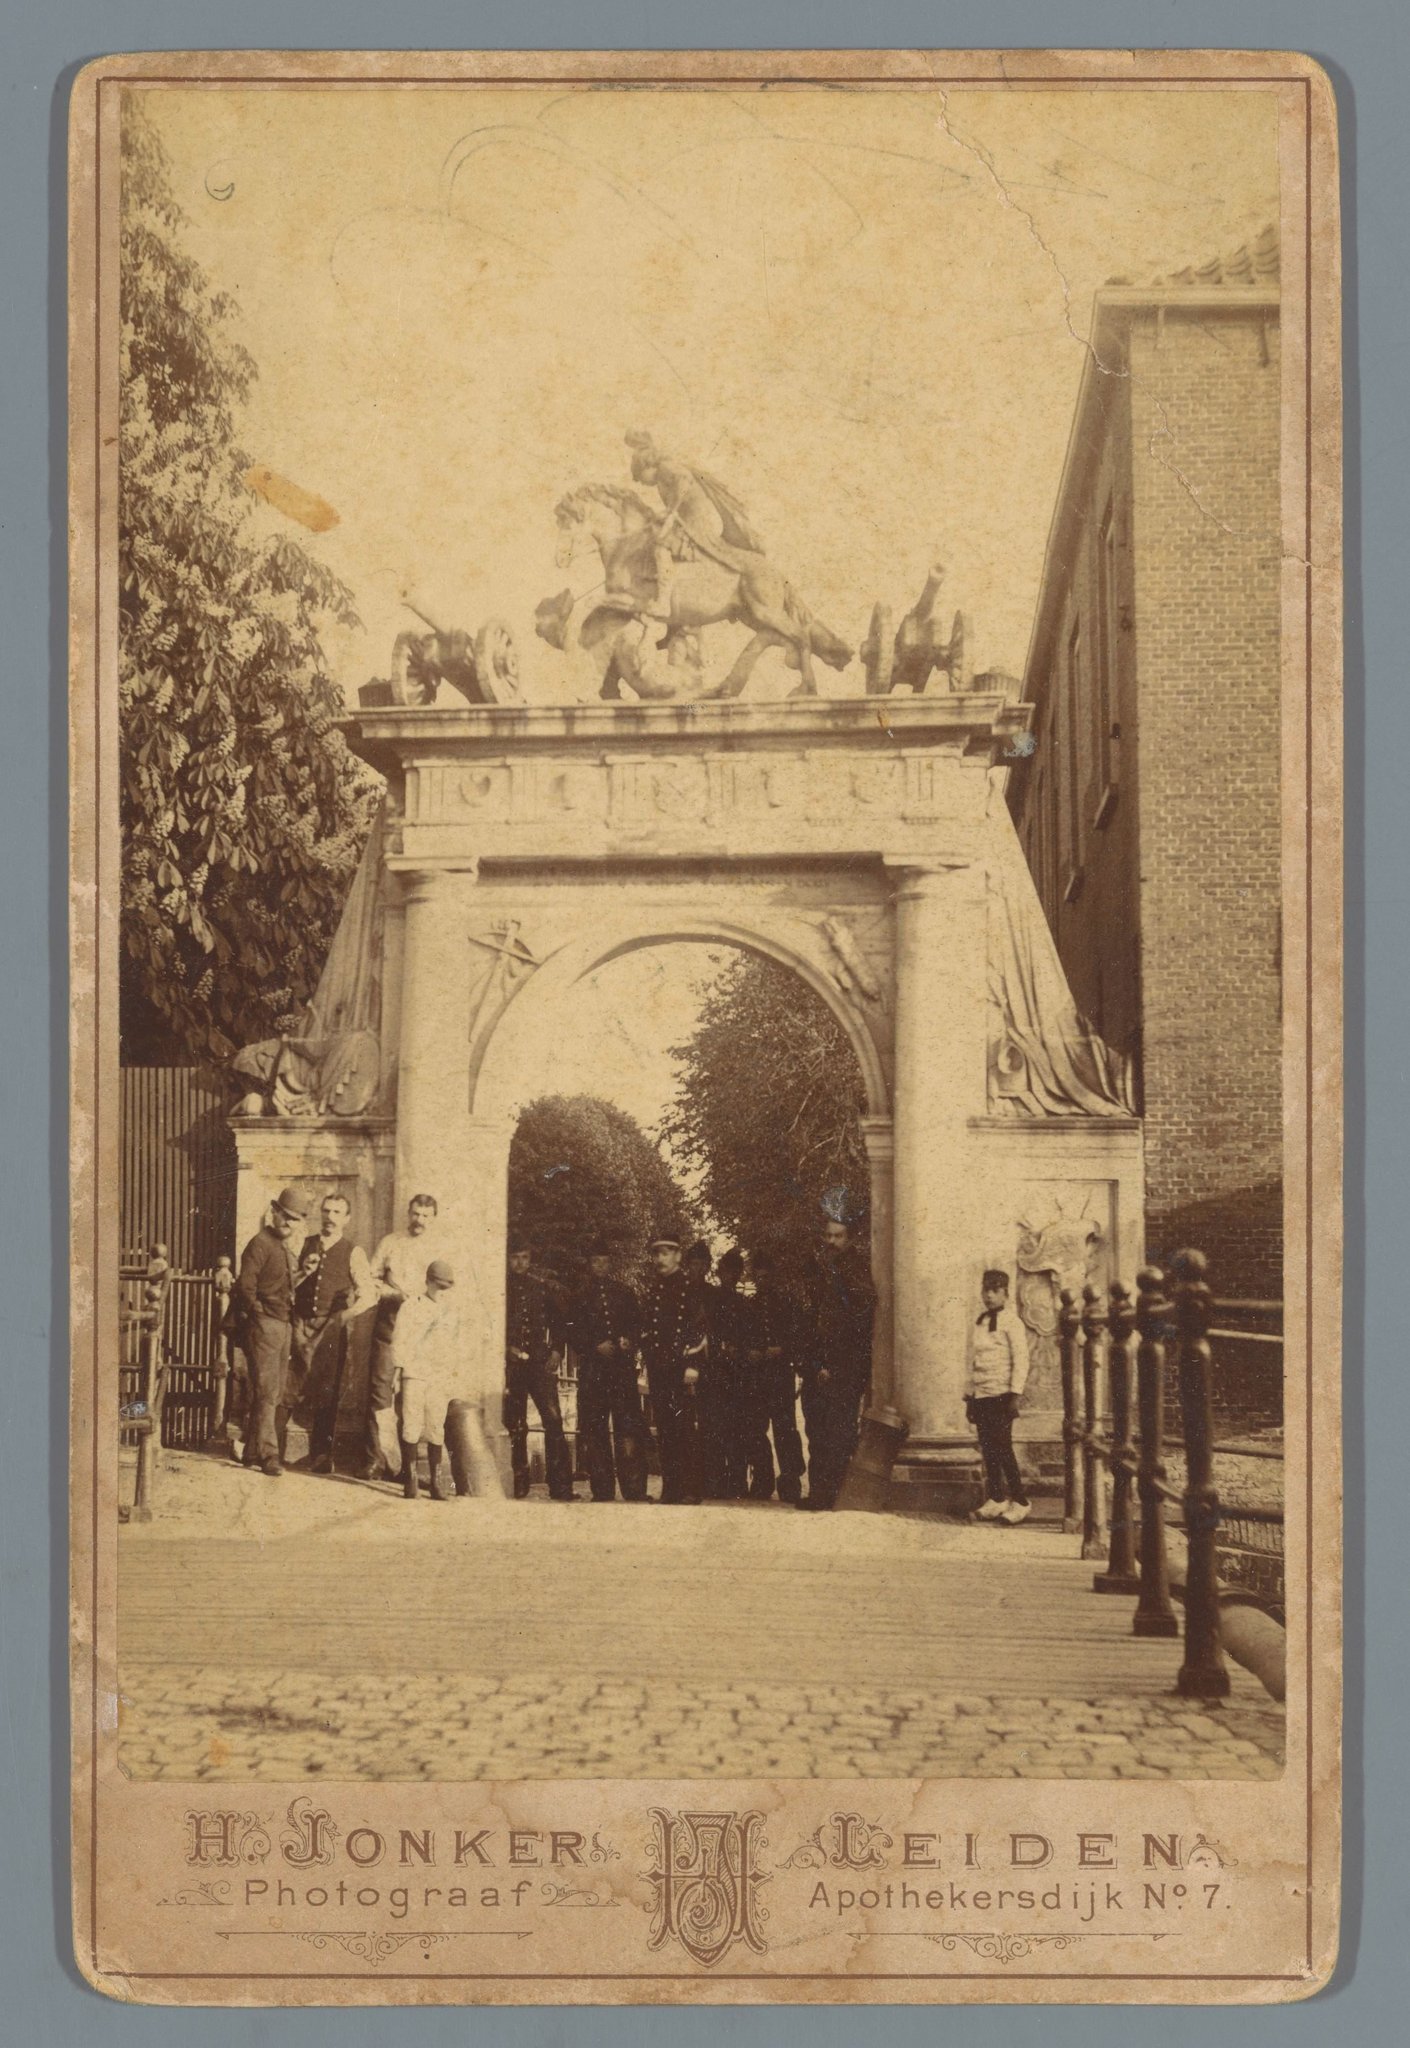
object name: photograph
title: Gezicht op de Doelenpoort te Leiden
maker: hendrik jonker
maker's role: fotograaf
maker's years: 1846-1932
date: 1850-1900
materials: cardboard, photographic support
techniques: albumen print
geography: leiden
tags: arch, archivolt ~ architecture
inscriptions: retailer's mark: ‘Carel F. P. Voget.’